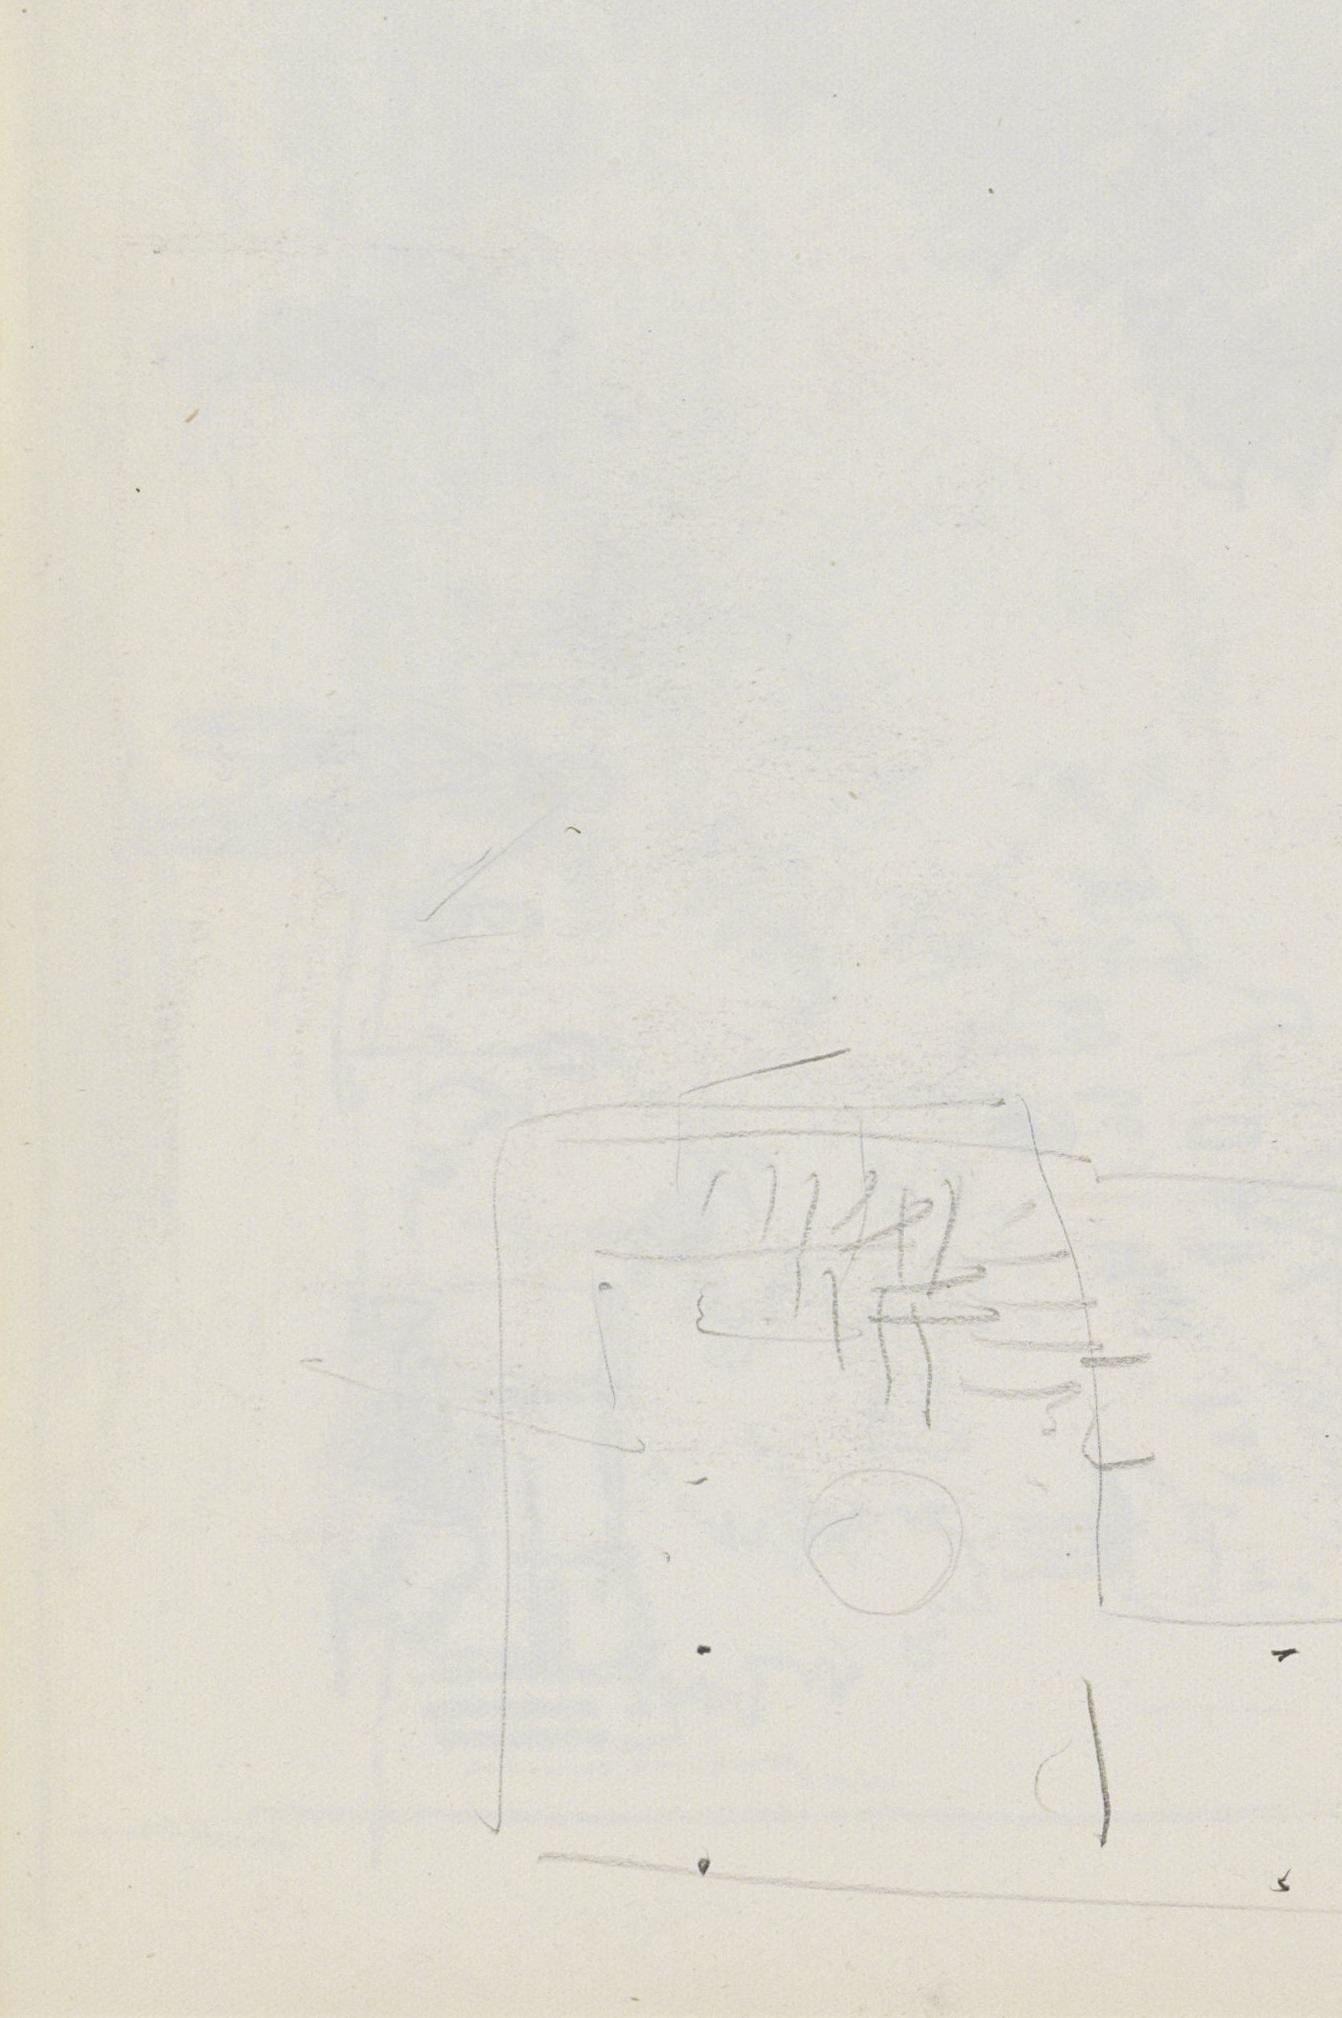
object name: sketchbook leaf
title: Studie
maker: cornelis vreedenburgh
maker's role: draughtsman, print maker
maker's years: 1880-1946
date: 1890-1946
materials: paper, pencil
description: Blad 40 verso uit een schetsboek met uit 75 bladen.